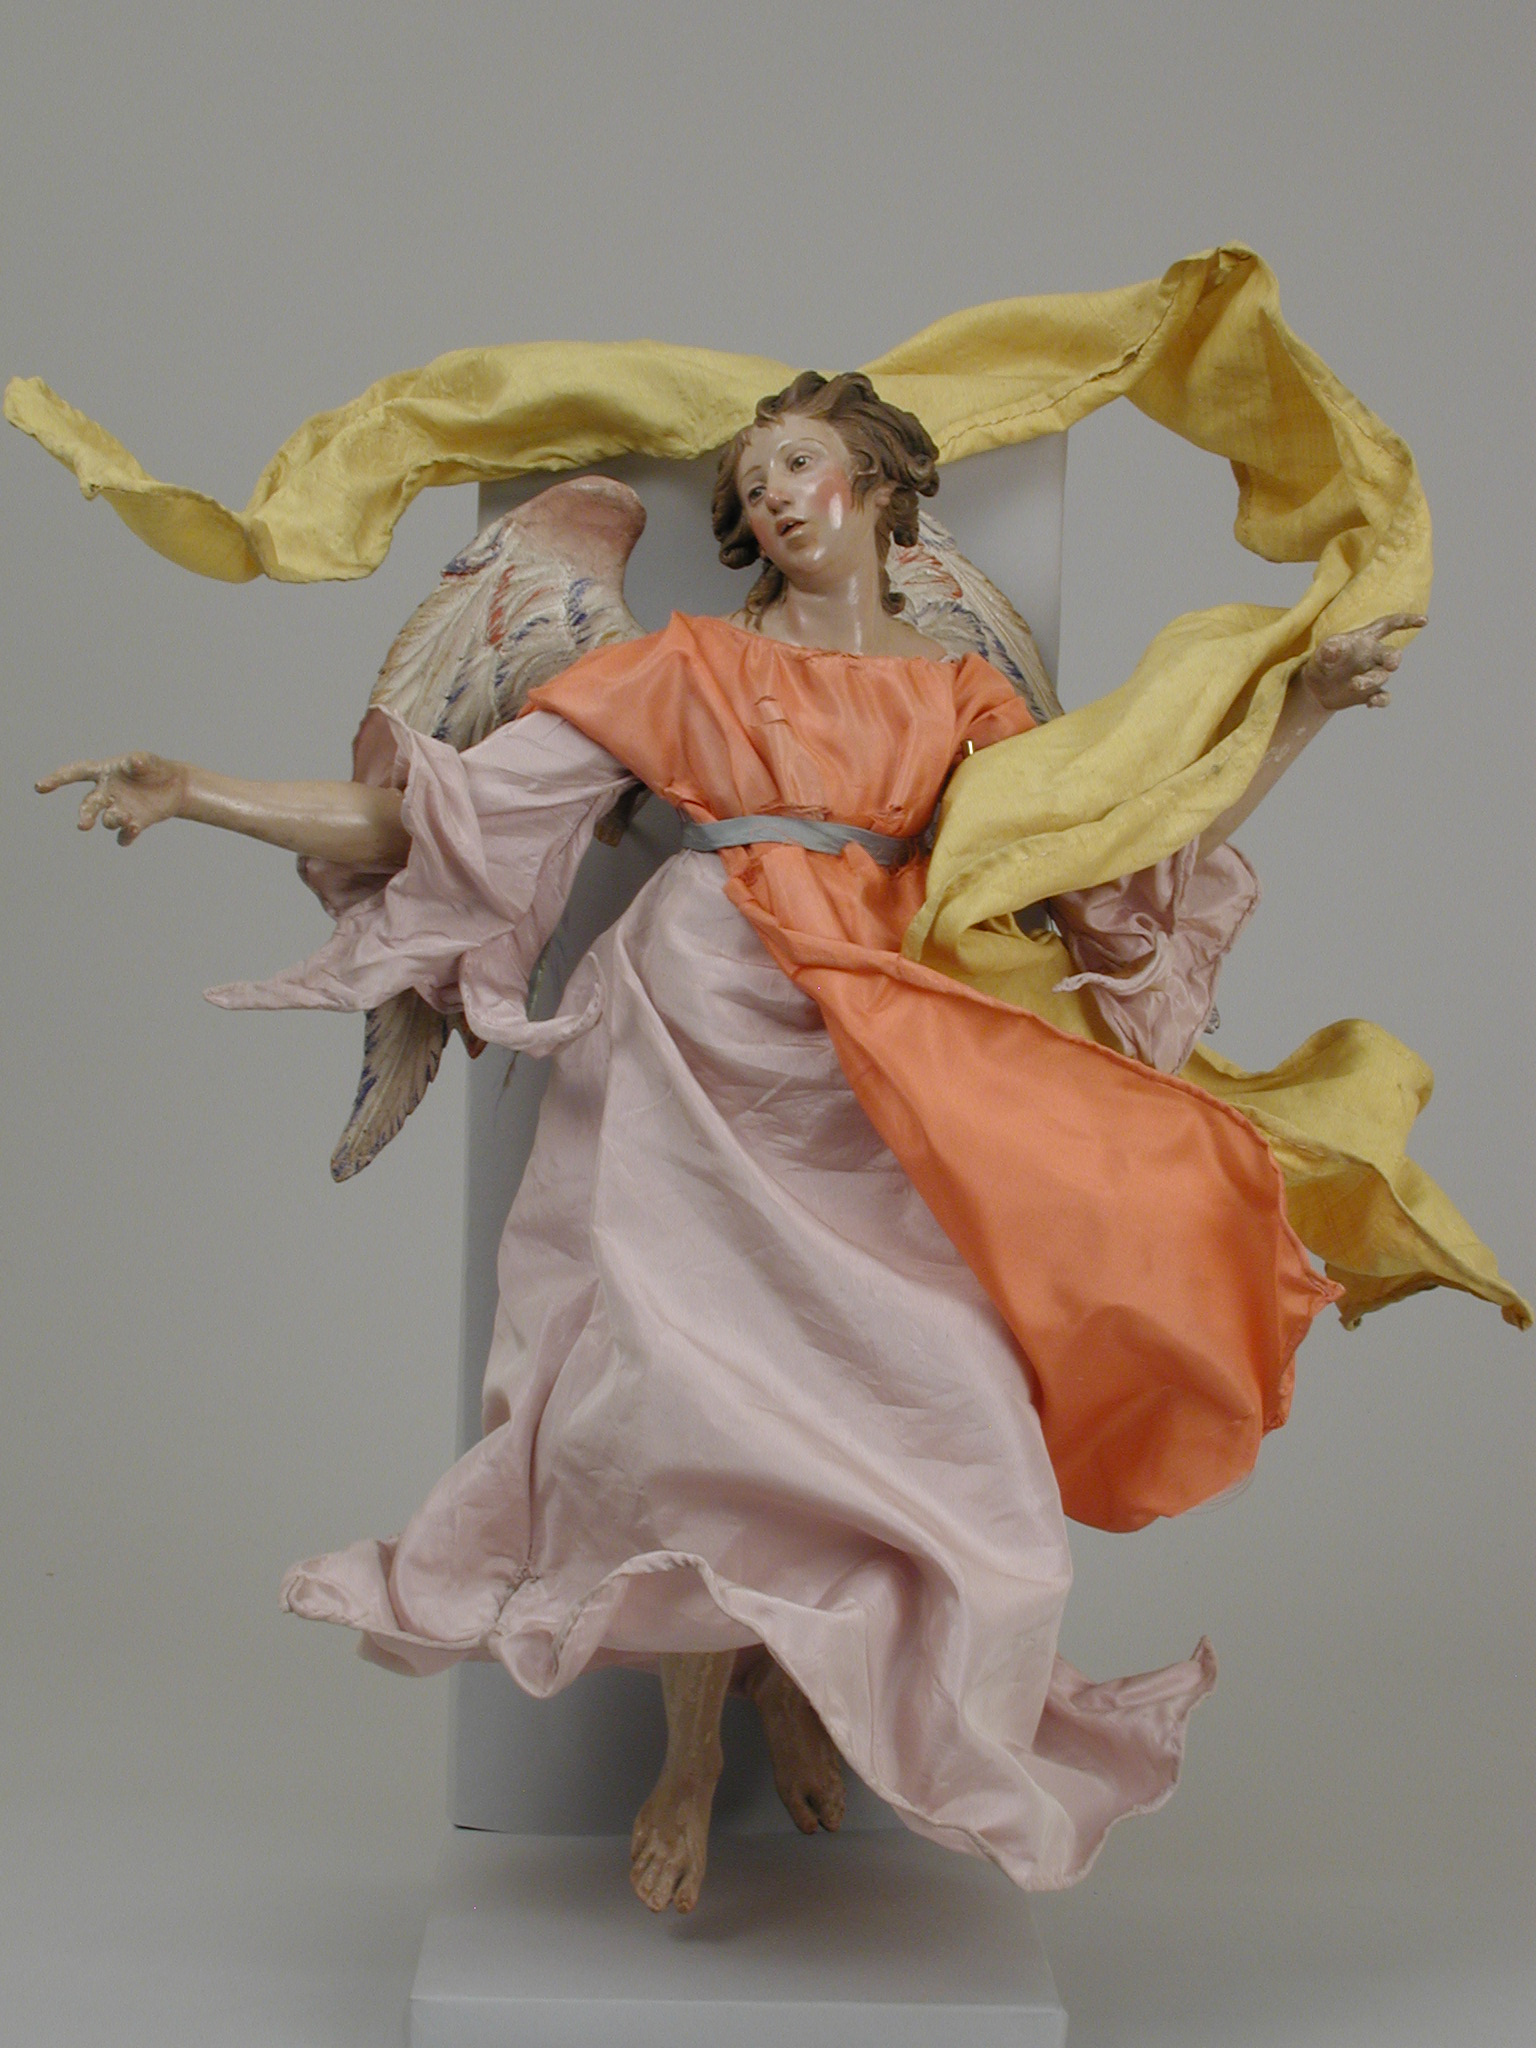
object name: crèche figure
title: Angel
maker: angelo viva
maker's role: maker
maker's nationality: italian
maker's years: 1748-1837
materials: terracotta, fiber, metal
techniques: polychrome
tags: angels